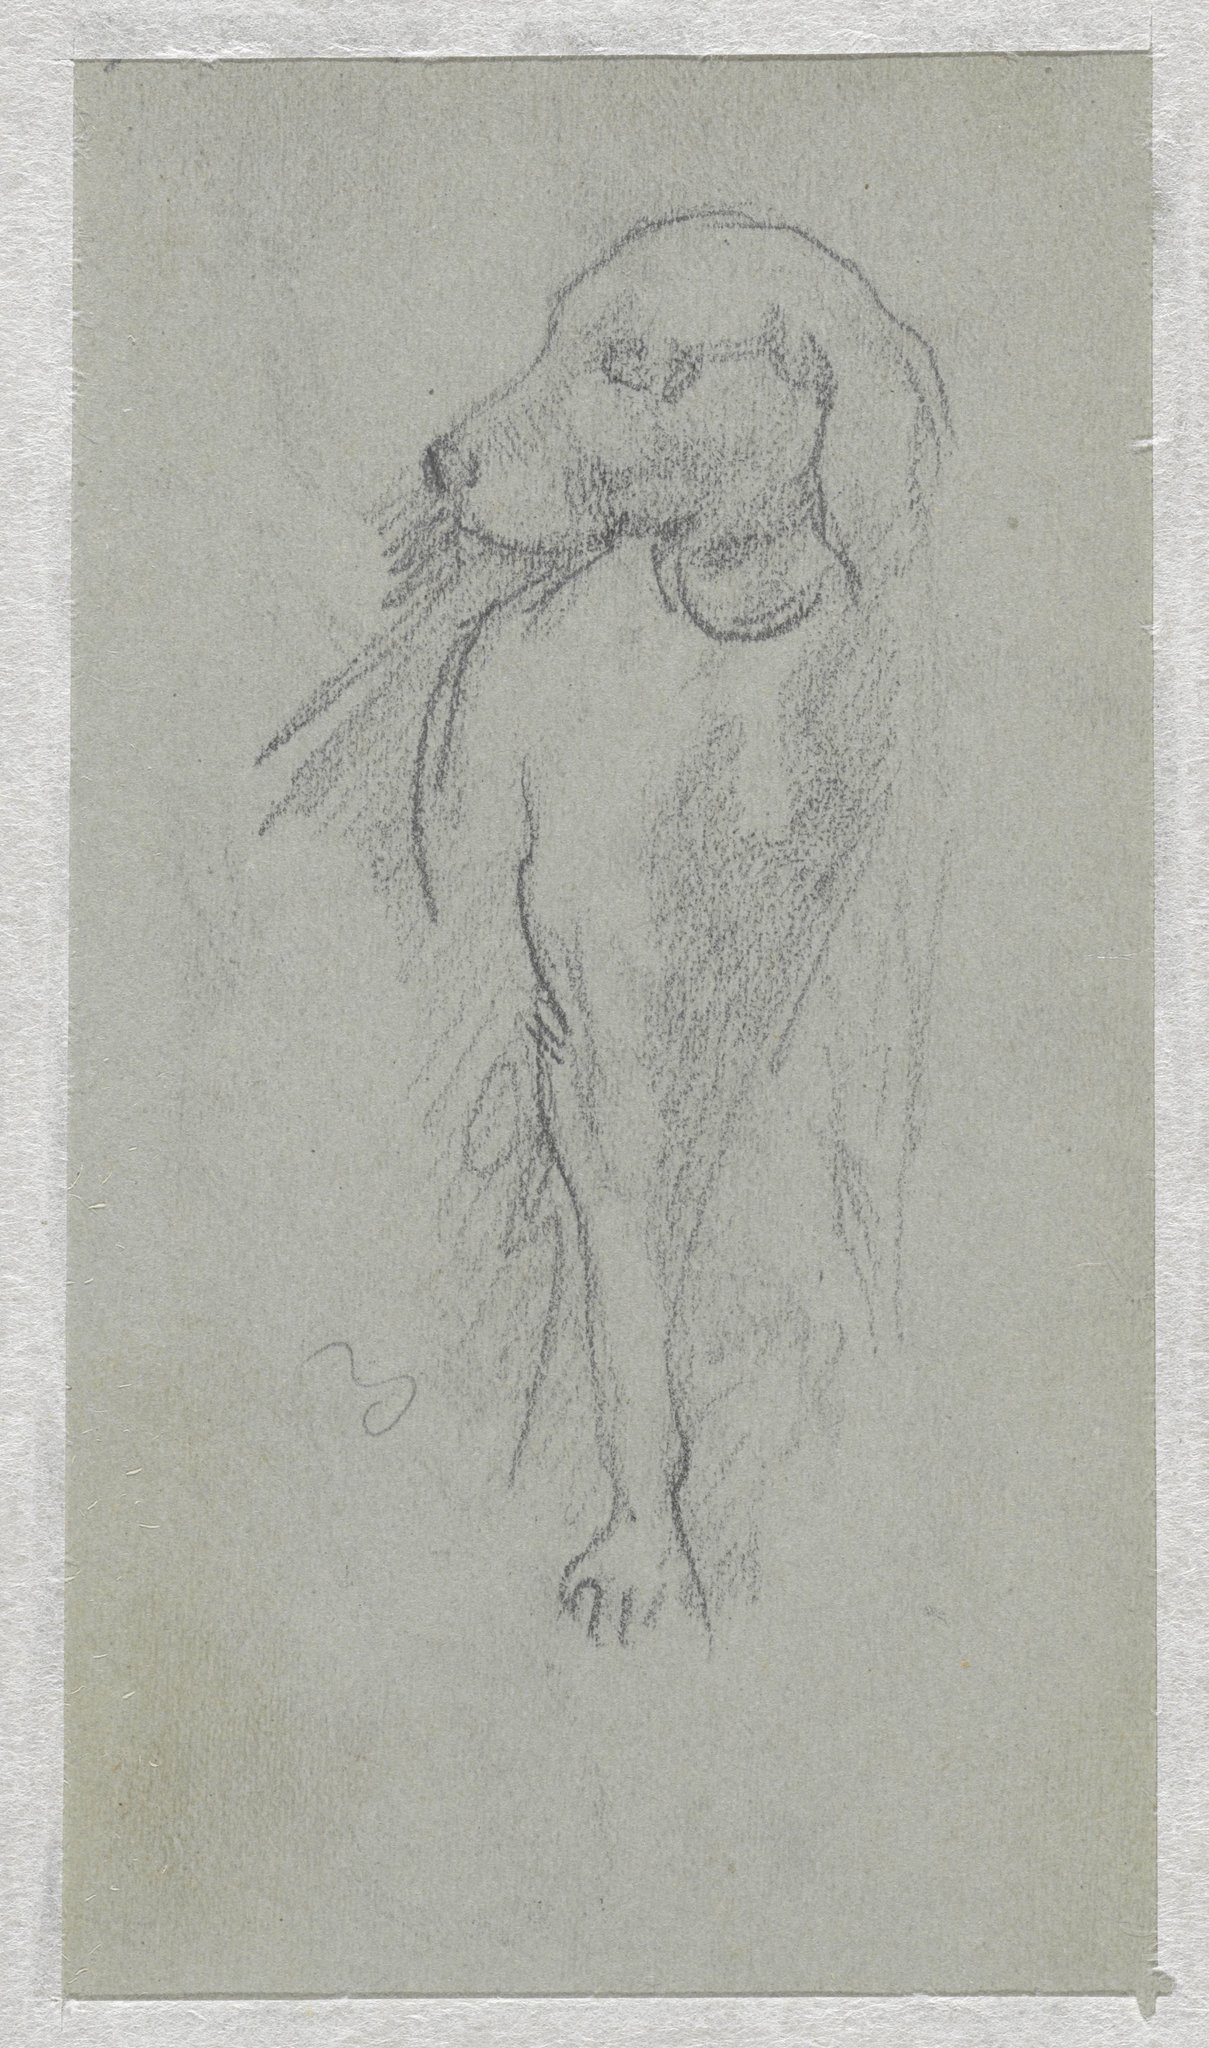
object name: drawing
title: Hond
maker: jacob maris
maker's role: draughtsman, painter, print maker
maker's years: 1837-1899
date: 1847-1899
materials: paper, pencil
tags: dog